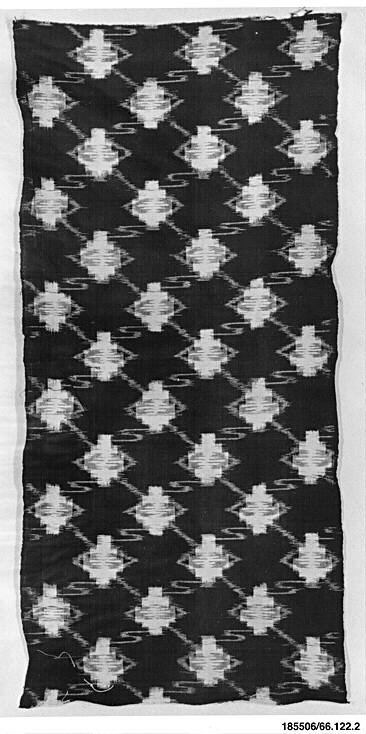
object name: piece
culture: japanese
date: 1801-1900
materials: cotton